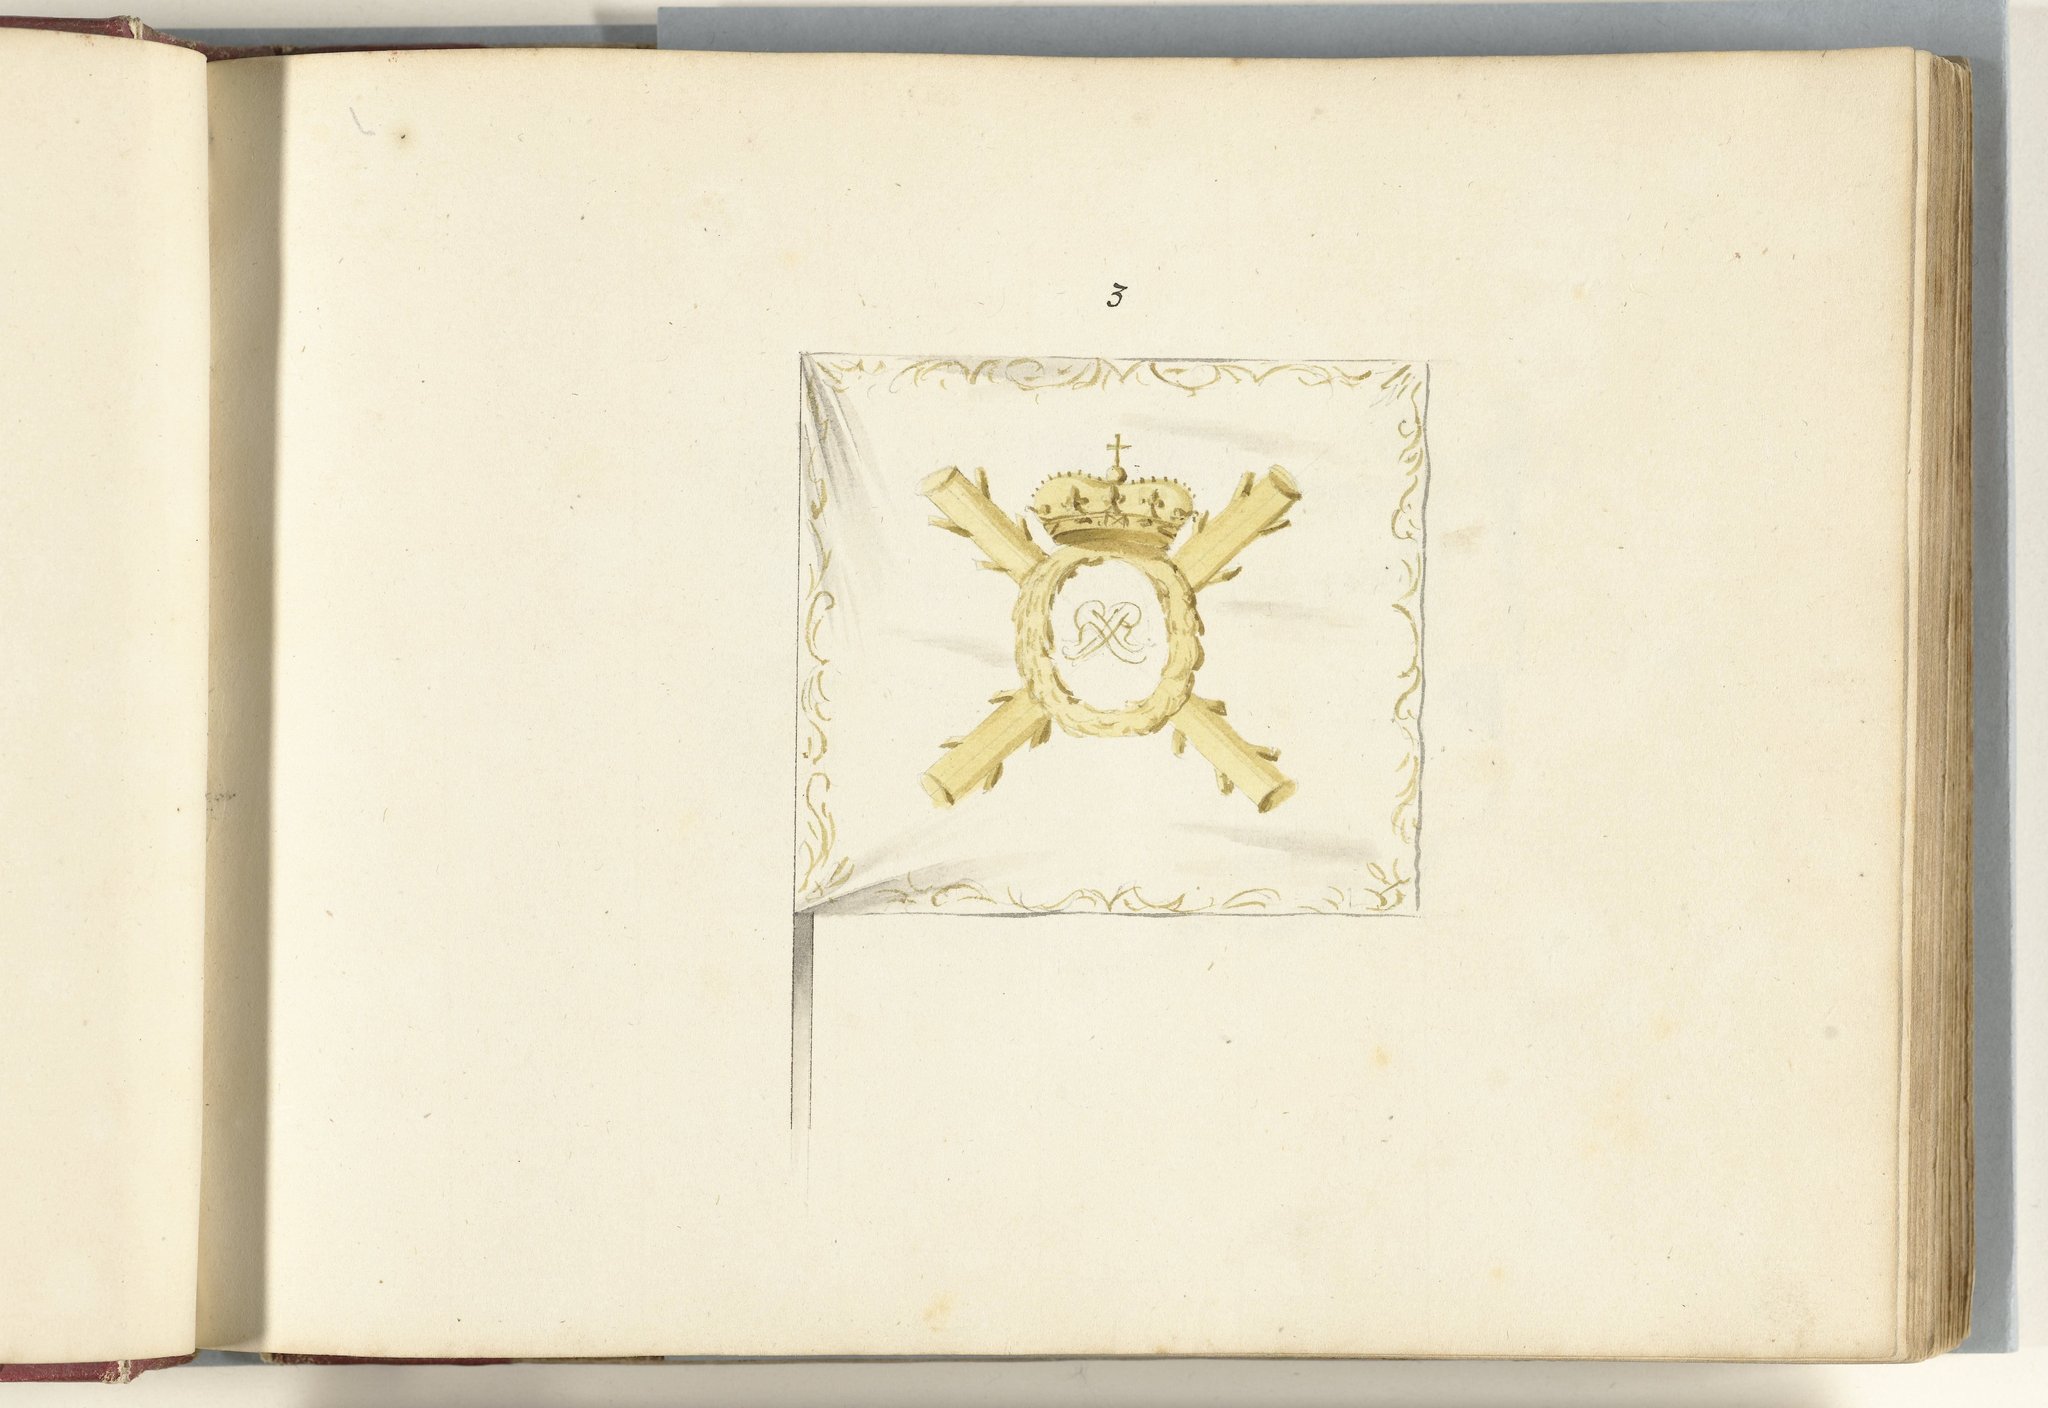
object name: drawing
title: Frans vaandel veroverd bij Oostende, 1706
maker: Anonymous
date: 1713-1720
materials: paper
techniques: drawing, writing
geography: northern netherlands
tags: (military) flags and standards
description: Frans vaandel veroverd bij Oostende, 1706. In het boek met tekeningen van Franse vaandels, standaarden en pauken, veroverd tijdens de Spaanse Successieoorlog (1701-1713).